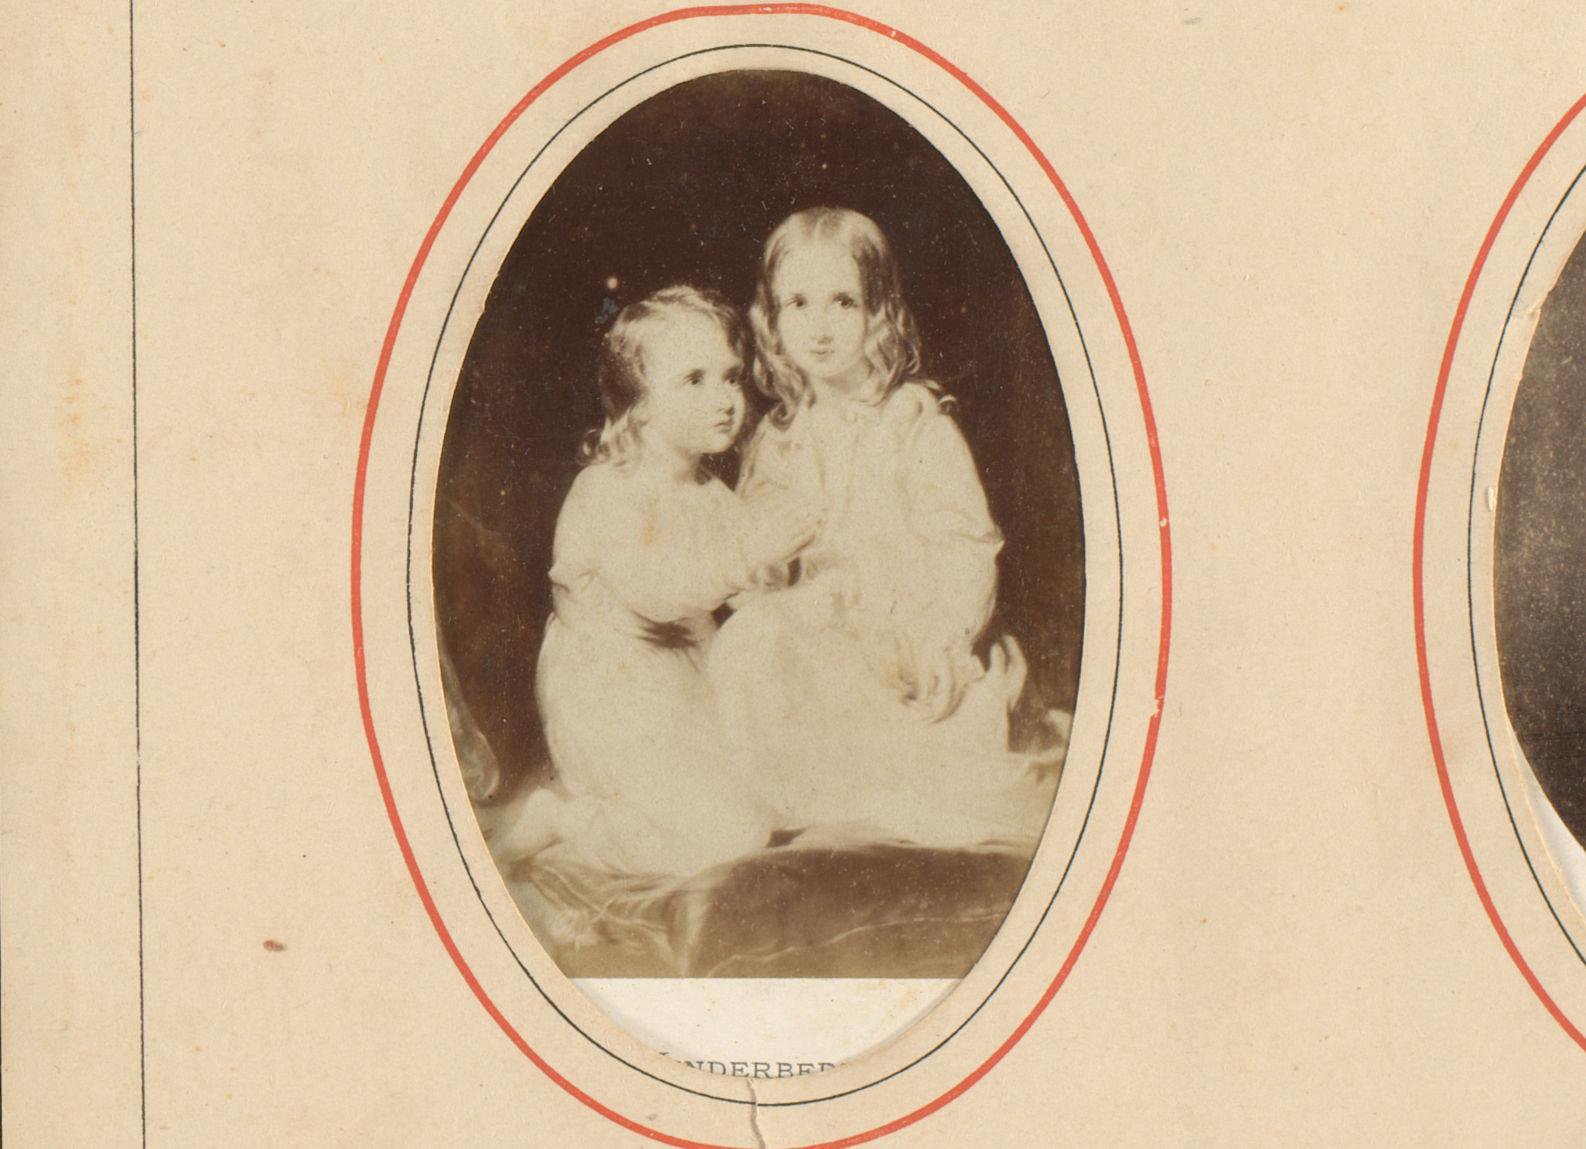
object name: reproduction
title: Kinderbede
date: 1870-1890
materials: cardboard, paper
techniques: albumen print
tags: child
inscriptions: inscription: ‘H. d. L.’, inscription: ‘Zoeter dan de dageraad/ Van een rozig lentedagjen,/ Is het allereerste lachjen (...)’